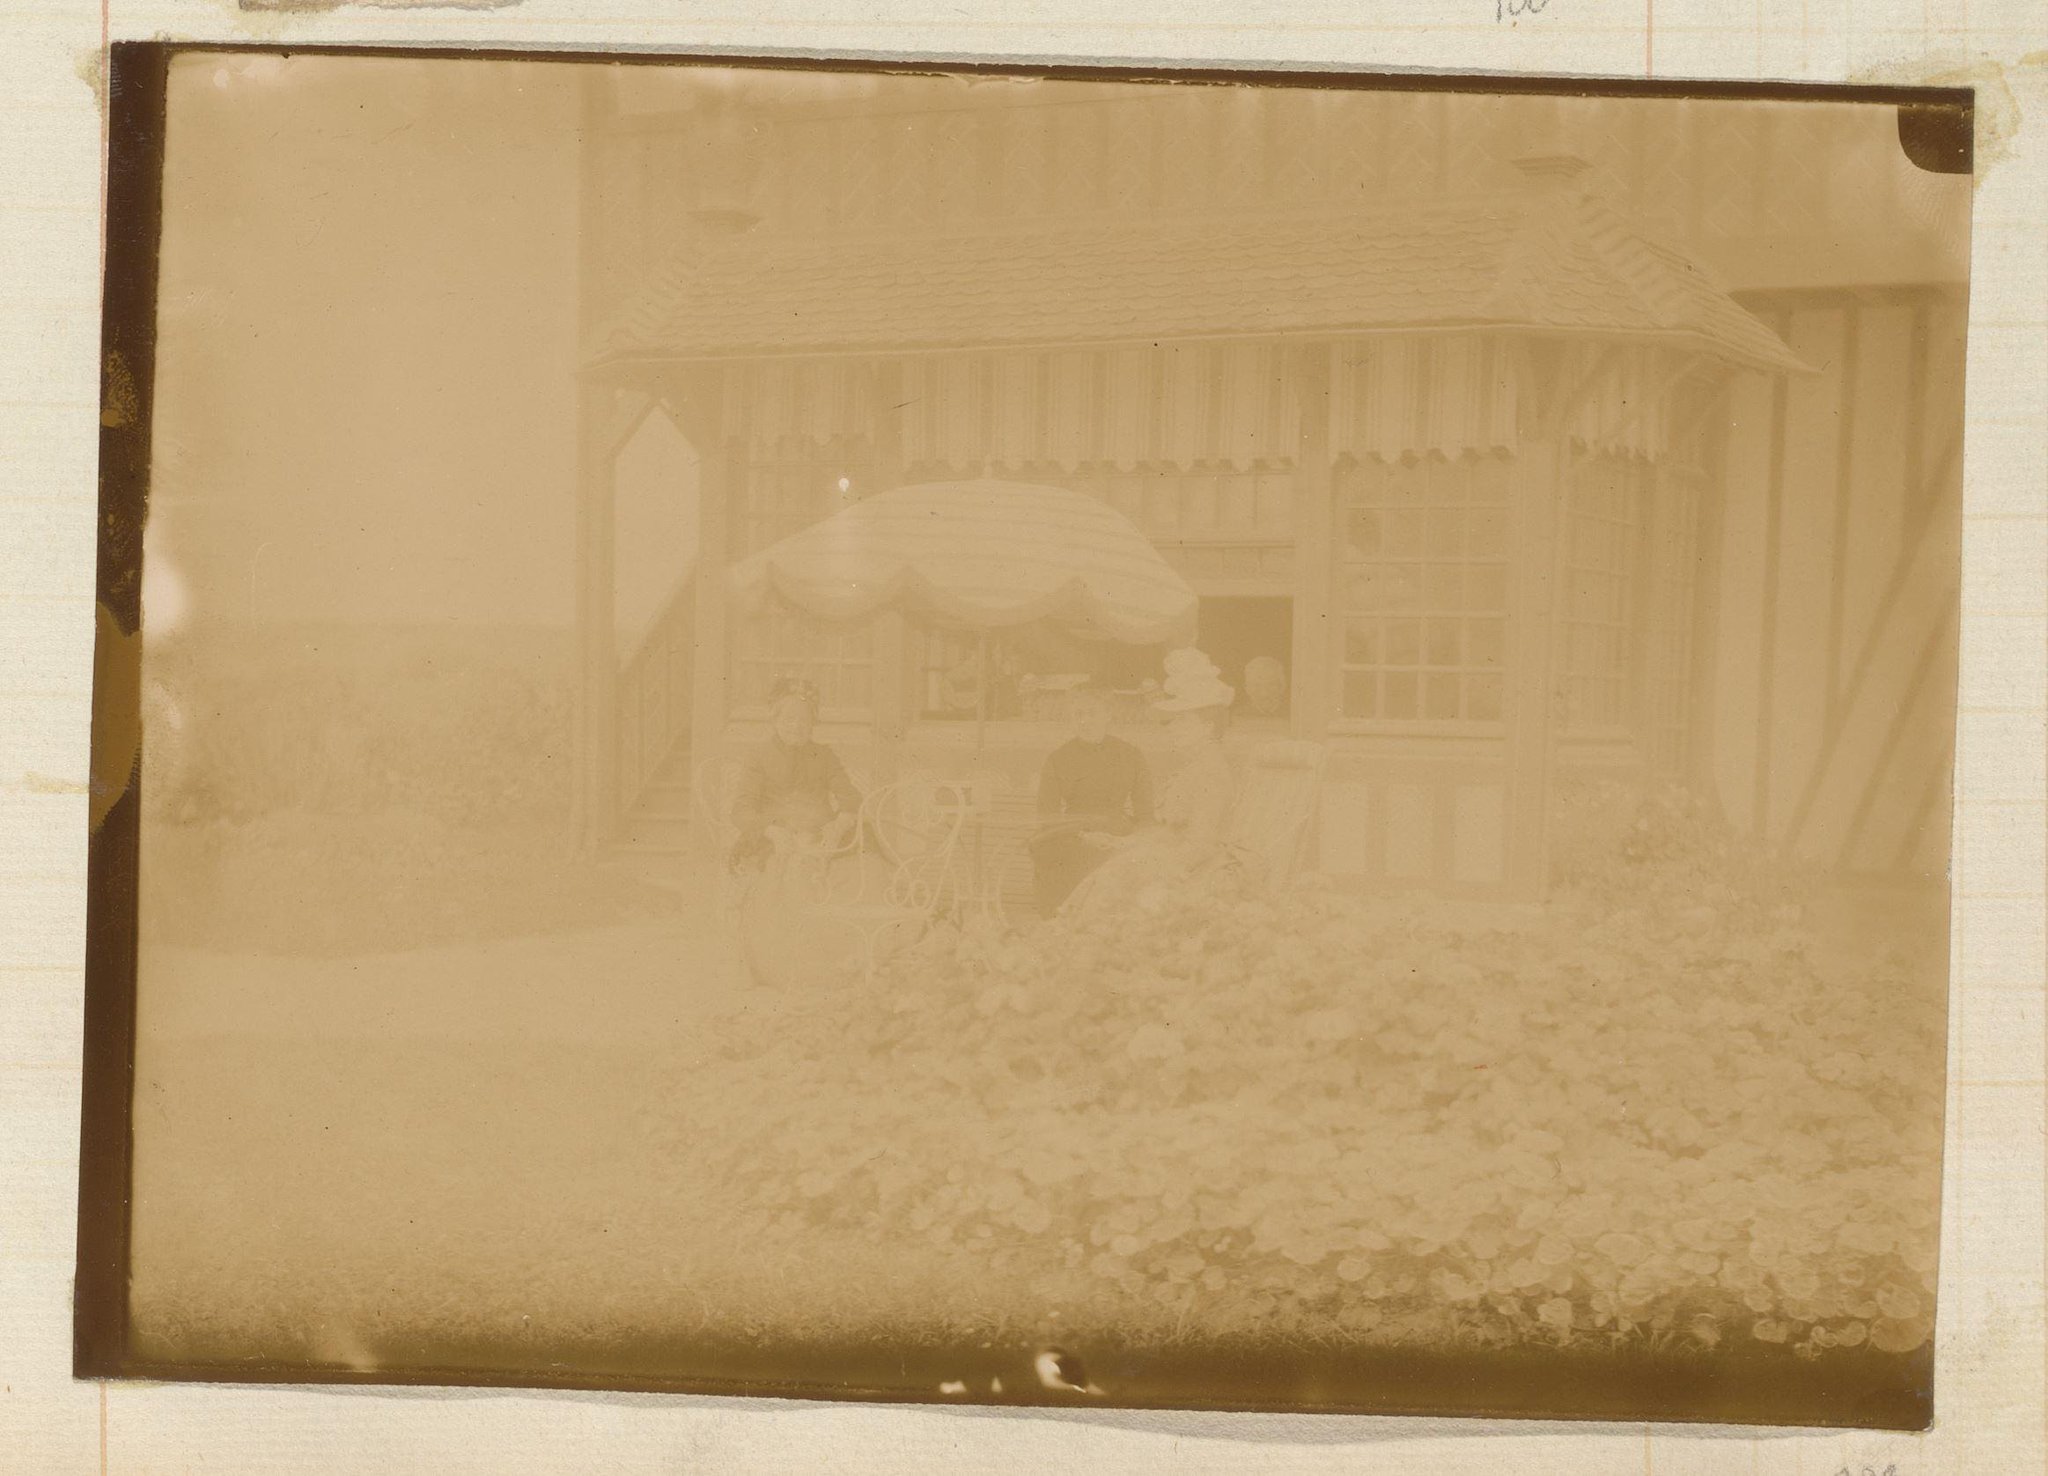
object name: photograph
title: Drie vrouwen zittend aan een tafel onder een parasol voor een vakwerkhuis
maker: Anonymous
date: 1880-1900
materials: paper, photographic support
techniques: gelatin silver print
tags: adult woman, rural housing, e.g. country-house, villa, cottage, parasol, sunshade